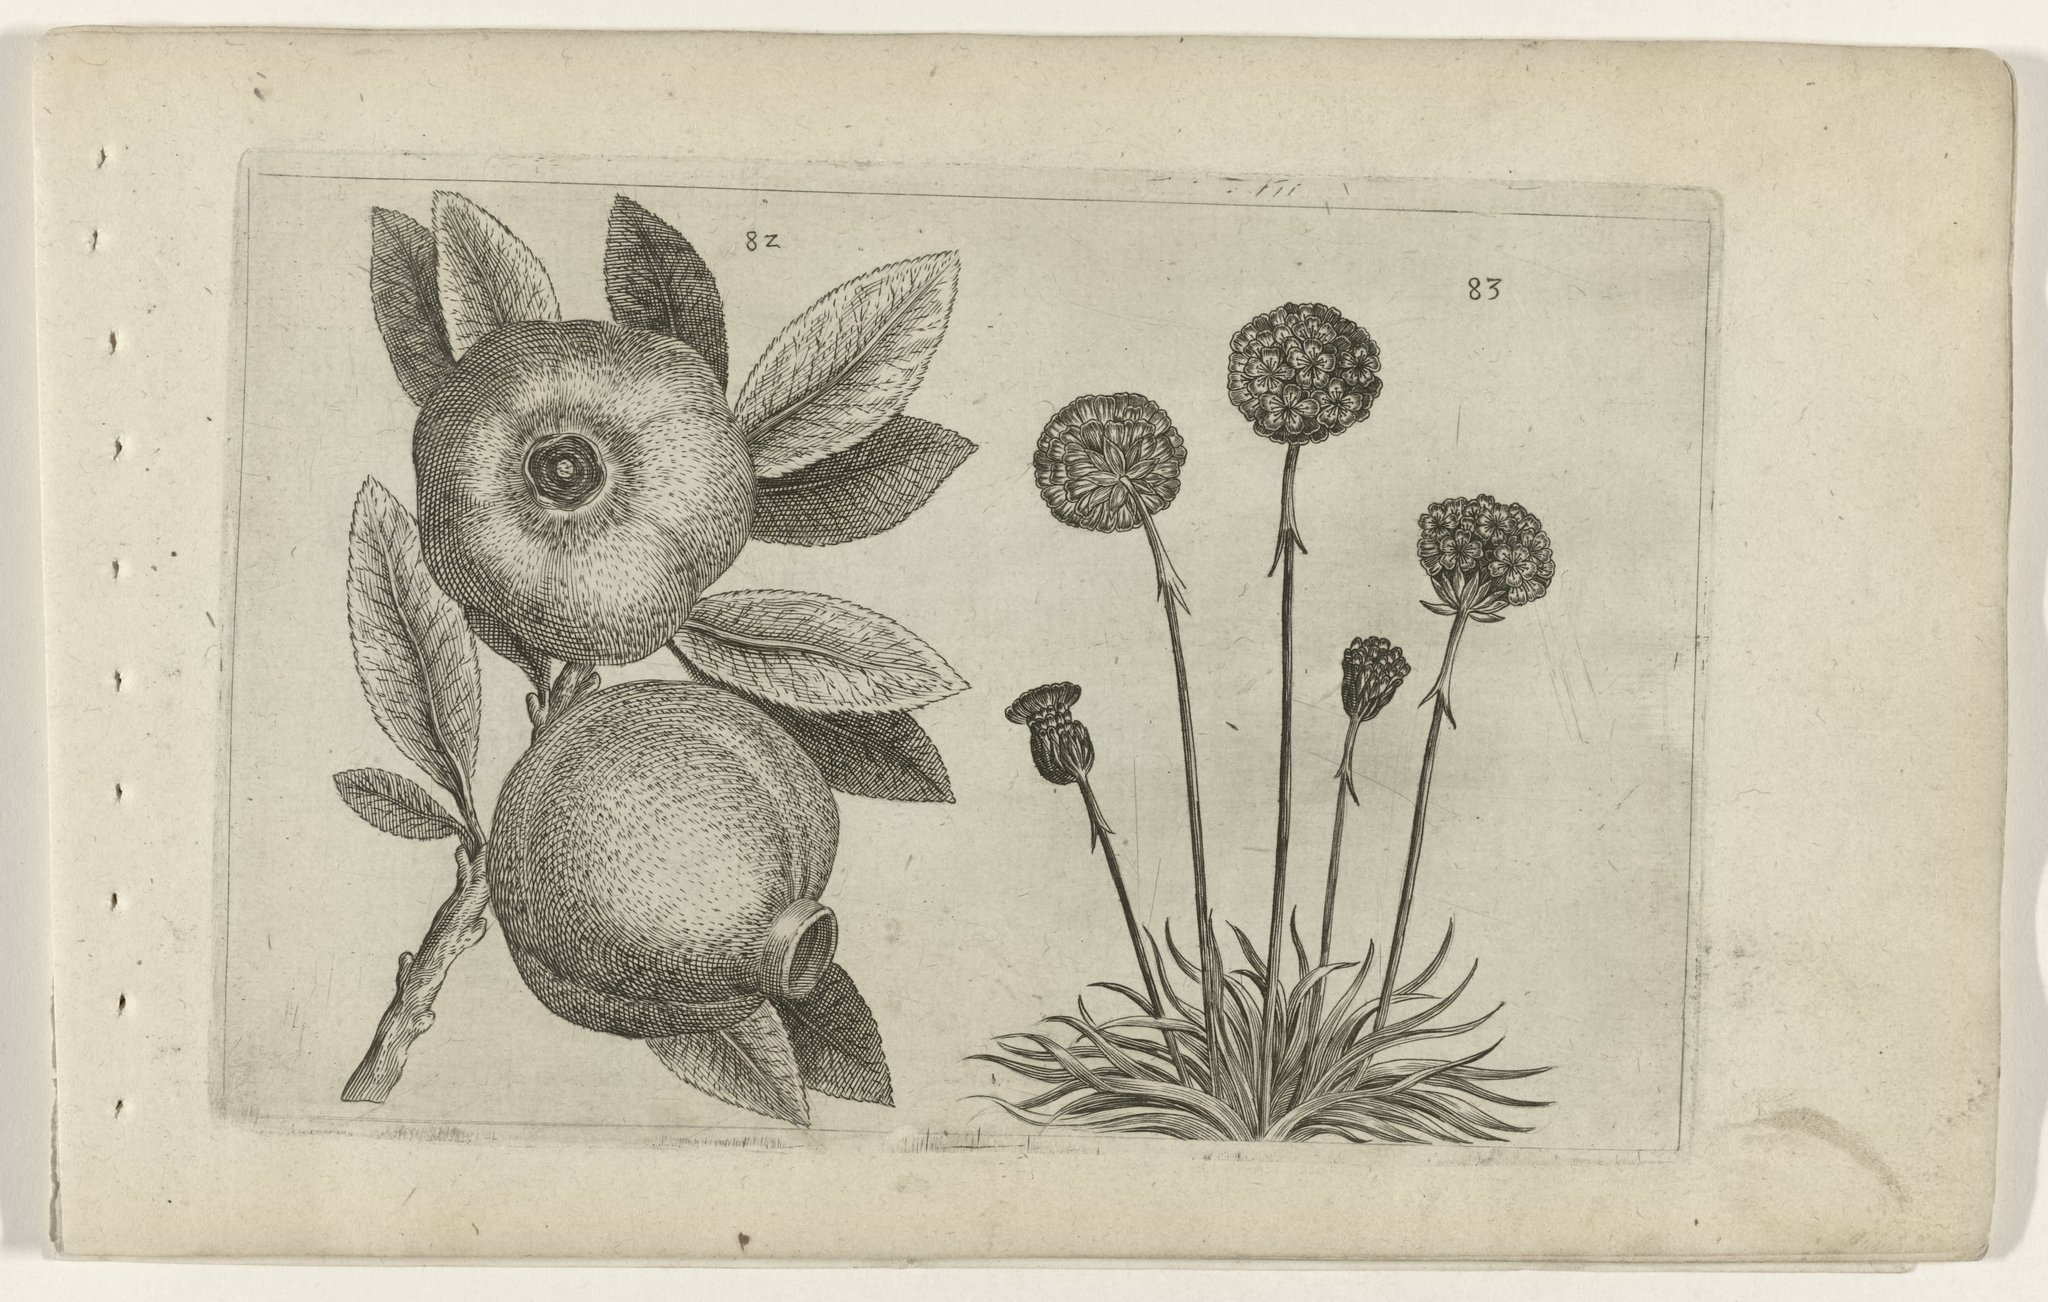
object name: print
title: Cognoscite lilia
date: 1600-1604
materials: paper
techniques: engraving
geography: cologne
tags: fruits: pomegranate, flowers: thrift, botany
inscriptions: collector's mark: Lugt 2228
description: De prenten RP-P-2012-24-1 t/m 61 waren oorspronkelijk als serie samengebonden. De naaigaten op de bladen zijn nog zichtbaar. Het betreft de reeks getiteld: Cognoscite lilia, bestaande uit een titelprent en 60 gravures met 119 genummerde weergaven van planten, bloemen en vruchten, versierd met rinceaux en kleine voorstellingen van dieren. Het gaat om proefdrukken van deze reeks gravures, voor de opschriften en, deels, voor de nummering. Op enkele prenten zijn de nummers met de hand aangebracht. Op de titelprent ontbreekt nog het adres van Crispijn de Passe en Hans Woutneel. De titel is hoogstwaarschijnlijk gegraveerd door Matthias Quad. Deze werkte voor De Passe in Keulen tot 1604. De reeks moet in dit jaar of daarvoor tot stand zijn gebracht. In ieder geval voor 1608, aangezien de uitgever Hans Woutneel in of voor dat jaar overleed. In ieder geval voor 1608, aangezien de uitgever Hans Woutneel in of voor dat jaar overleed. De gravures worden door Ilja Veldman en Anthony Griffiths beschouwd als eigenhandig werk van Crispijn de Passe I. Een van de prenten uit de reeks ontbreekt (nr 21-22) en is vervangen door een ingekleurde afdruk uit een latere uitgave (RP-P-2012-24-61), die onder de titel Altera Pars is opgenomen in de Hortus Floridus, uitgegeven door Crispijn de Passe I en die verder bestaat uit platen van Crispijn de Passe II. De prenten afkomstig uit deze uitgave zijn op de verso voorzien van tekst in boekdruk. De vervangende prent maakte geen deel uit van de gebonden serie aangezien dit blad als enige geen naaigaten heeft. Een deel van de planten, bloemen en vruchten in de Cognoscite lilia gaat terug of is gebaseerd op een reeks aquarellen van Jacques LeMoyne uit circa 1580 en uit 1585, nu in het Victoria and Albert Museum en de British Museum (zie P. Hulton, Jacques LeMoyne, Londen 1977, dl 1, p. 156-162 en p. 165-173).